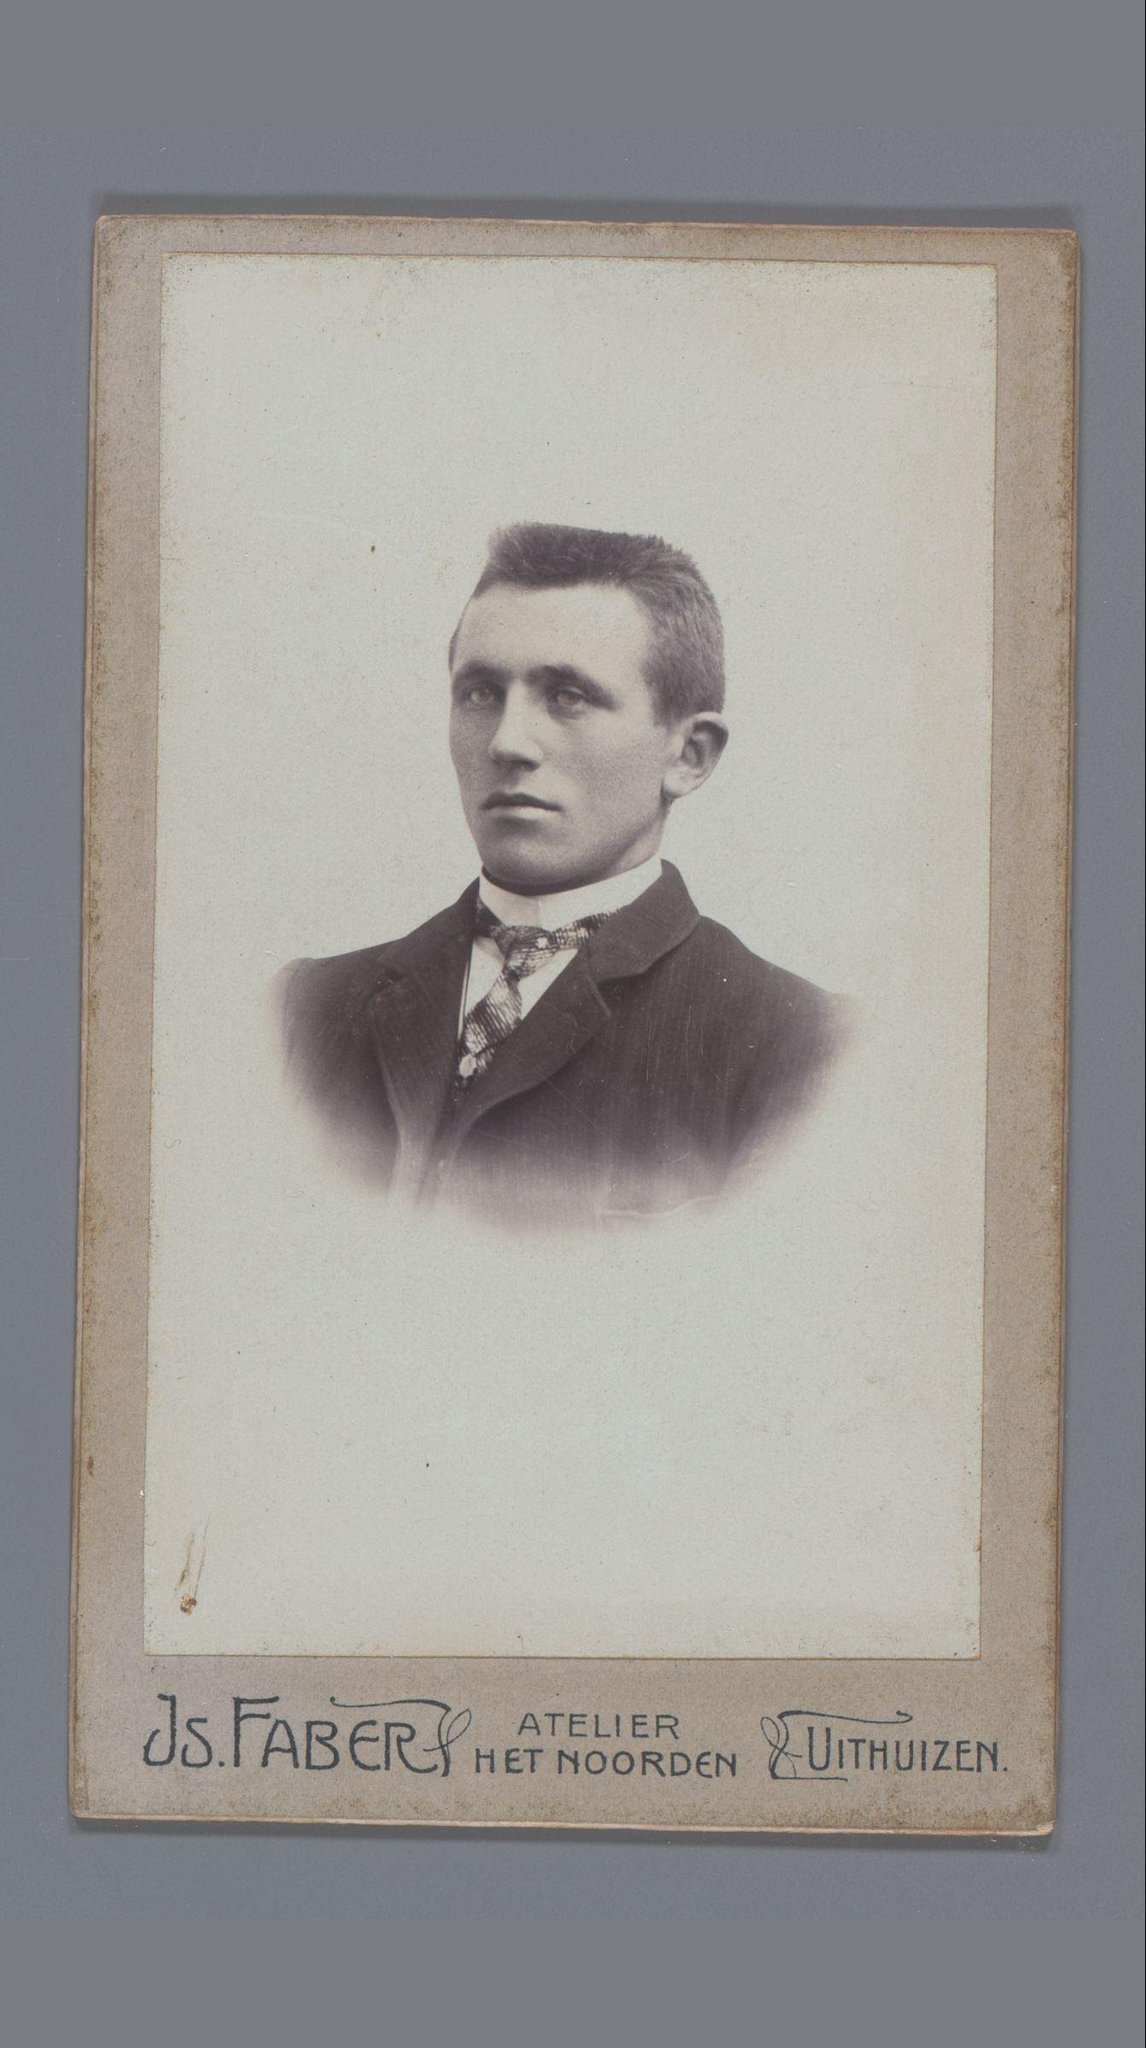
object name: carte de visite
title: Portret van een onbekende man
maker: jannes faber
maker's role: fotograaf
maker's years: 1874-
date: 1897-1909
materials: paper, cardboard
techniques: collodion silver print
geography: uithuizen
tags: adult man, anonymous historical person portrayed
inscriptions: inscription: ‘Specialiteit in/ Vergrootingen/ en Crayonteekeningen/ naar elk portret.’, inscription: ‘ATELIER/ HET NOORDEN’